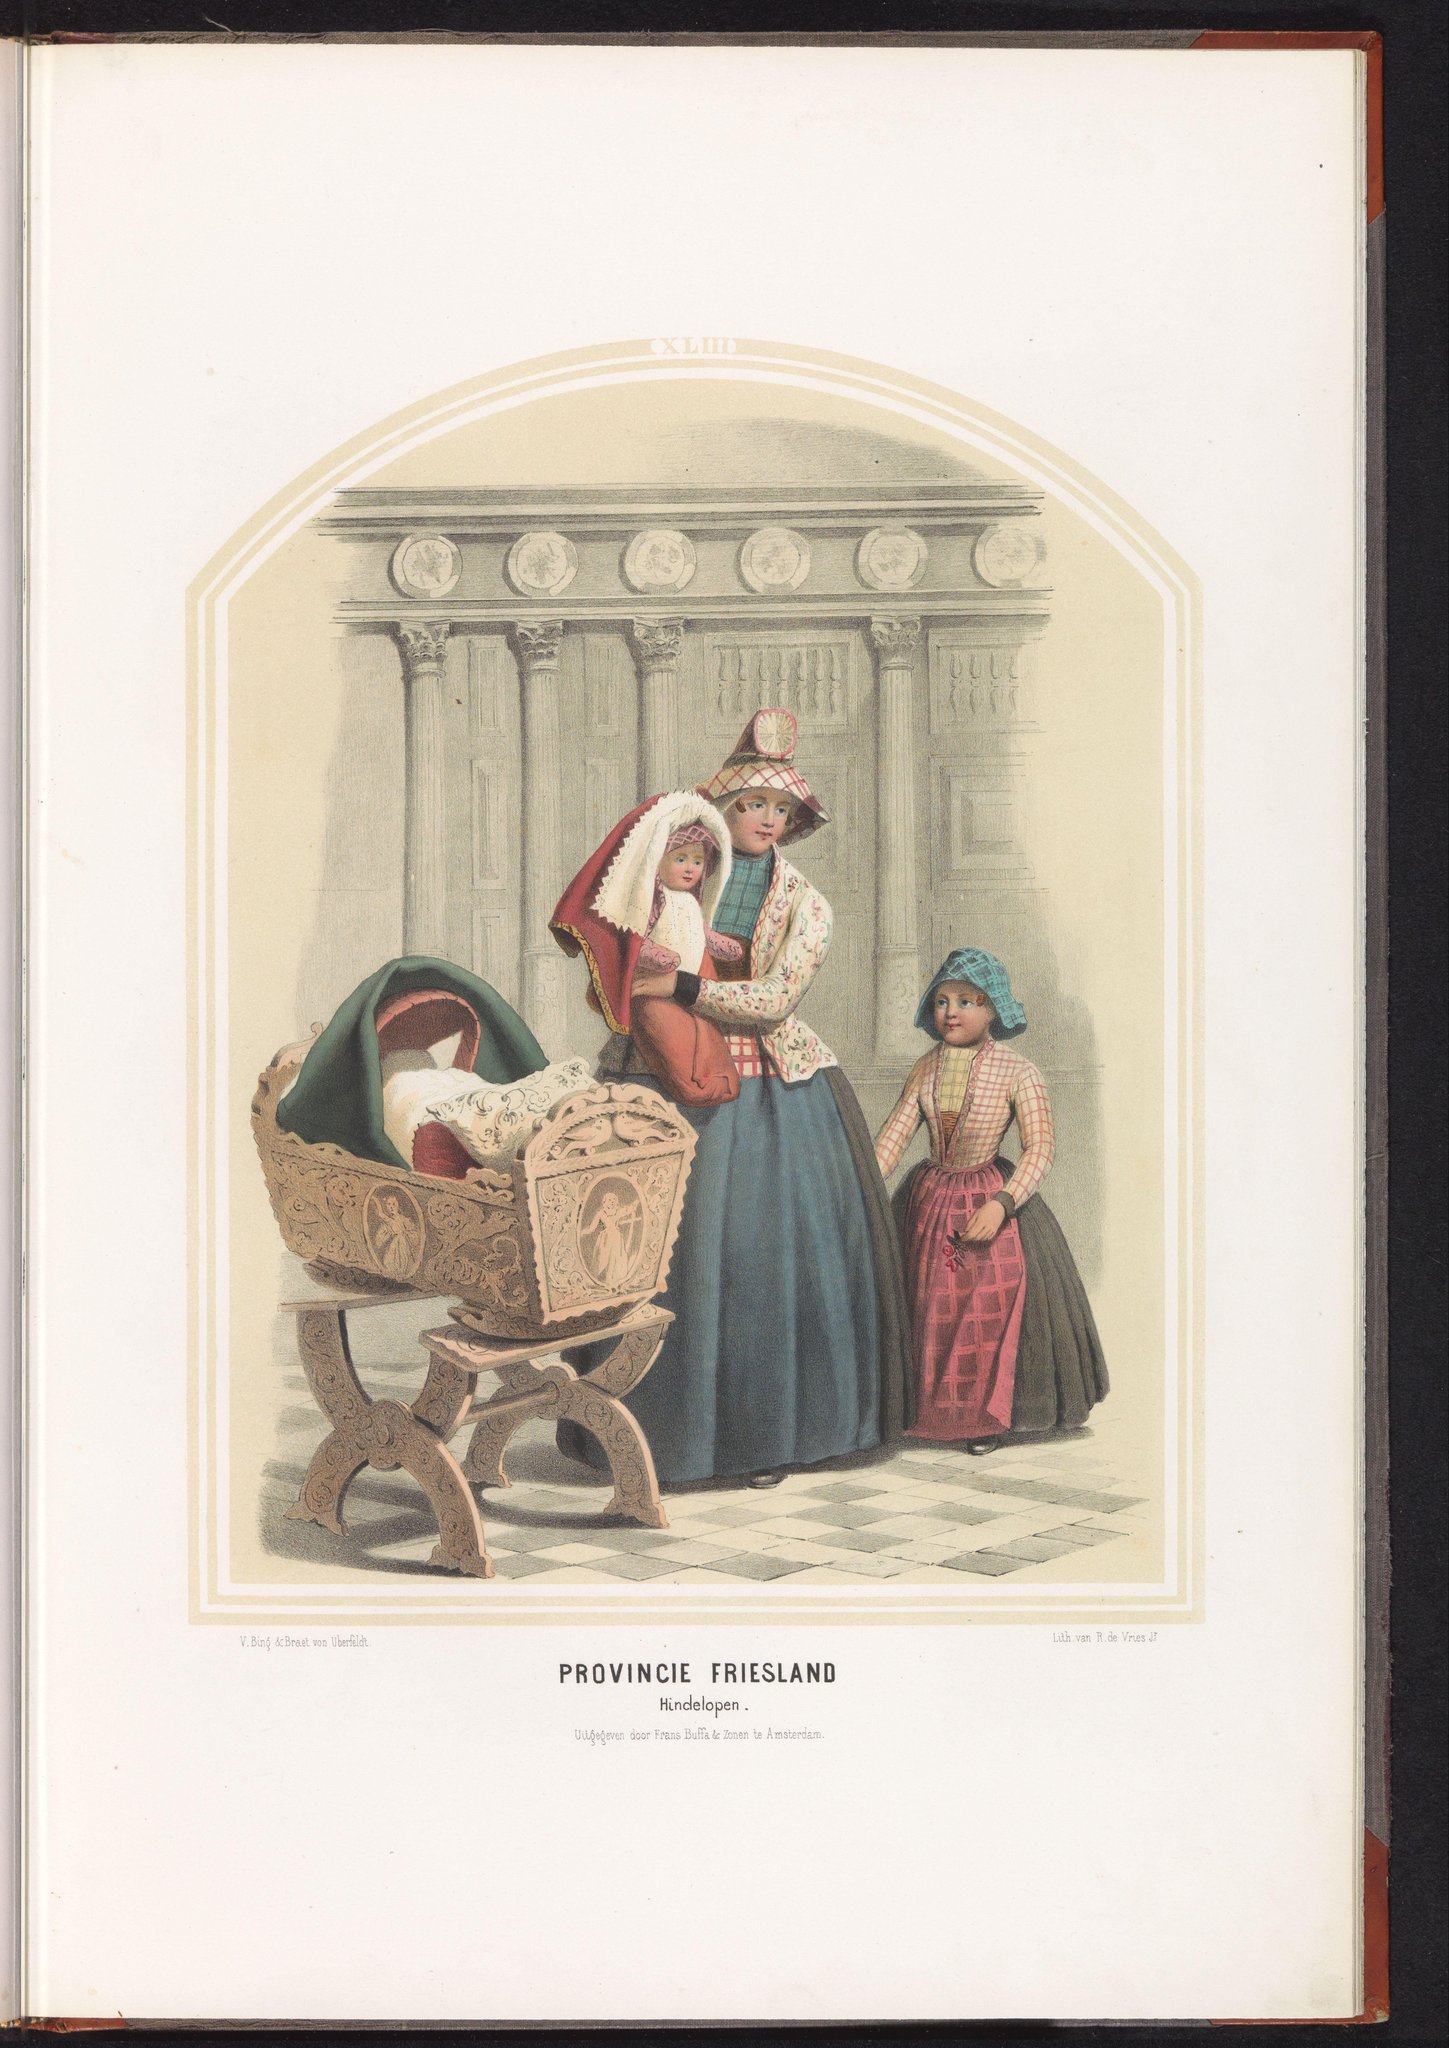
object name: costume print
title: Provincie Friesland. Hindelopen / XLIII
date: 1857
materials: paper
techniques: hand coloring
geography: amsterdam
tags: folk costume, regional costume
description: Klederdracht van de plaats Hindeloopen in de provincie Friesland. Moeder met twee kinderen. Illustratie in een boek uit 1857 met 56 platen van Nederlandse klederdrachten.